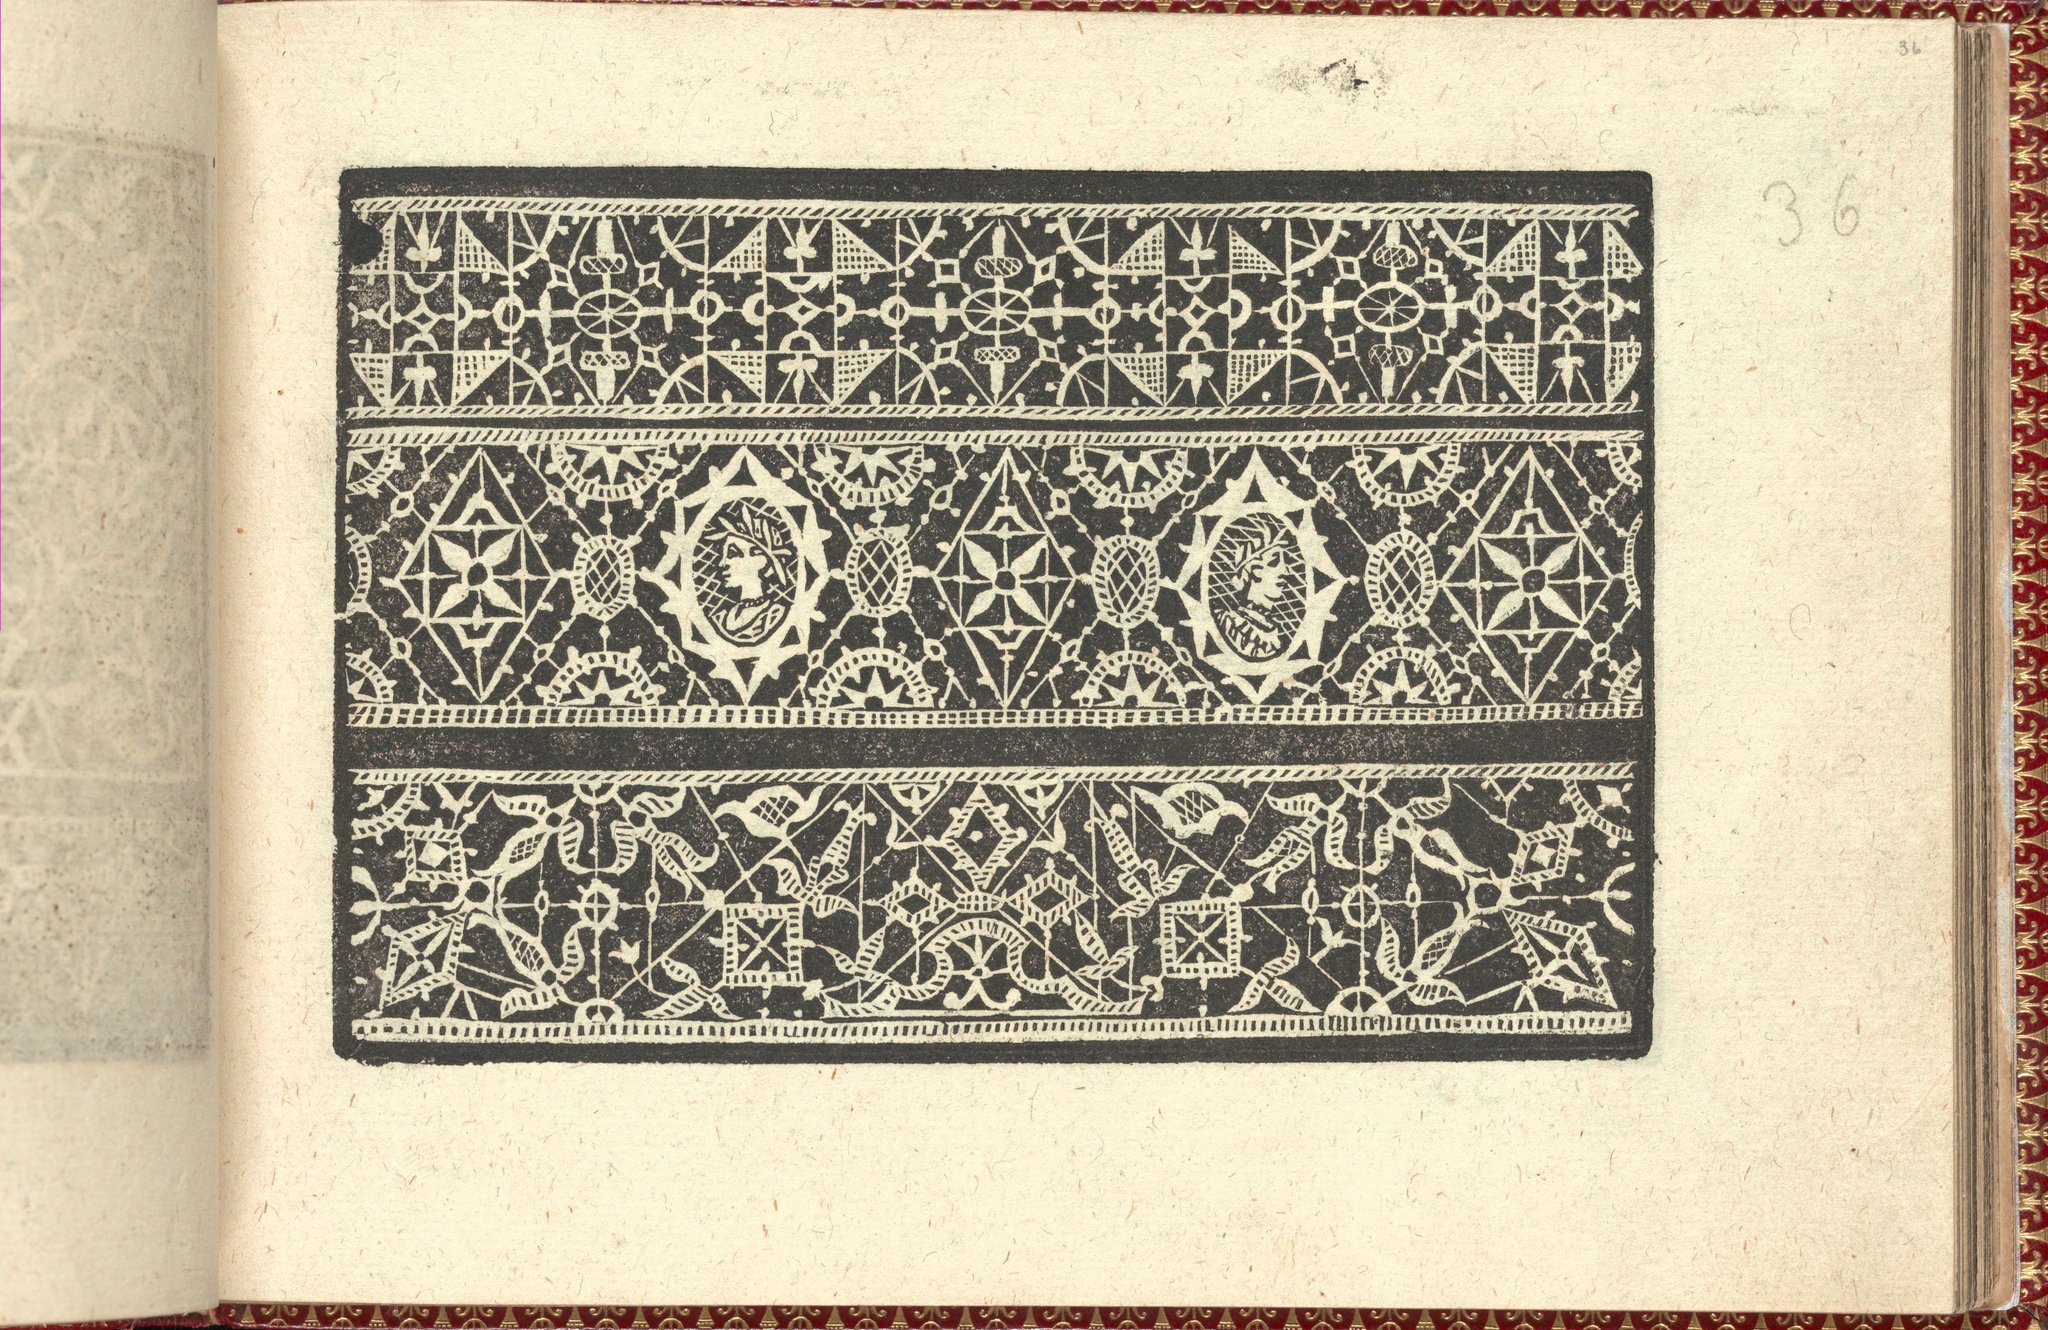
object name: book print ornament architecture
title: Corona delle Nobili et Virtuose Donne: Libro I-IV, page 36 (recto)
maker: cesare vecellio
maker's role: publisher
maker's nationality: italian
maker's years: 1521-1601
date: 1601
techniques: woodcut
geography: italy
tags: ornament